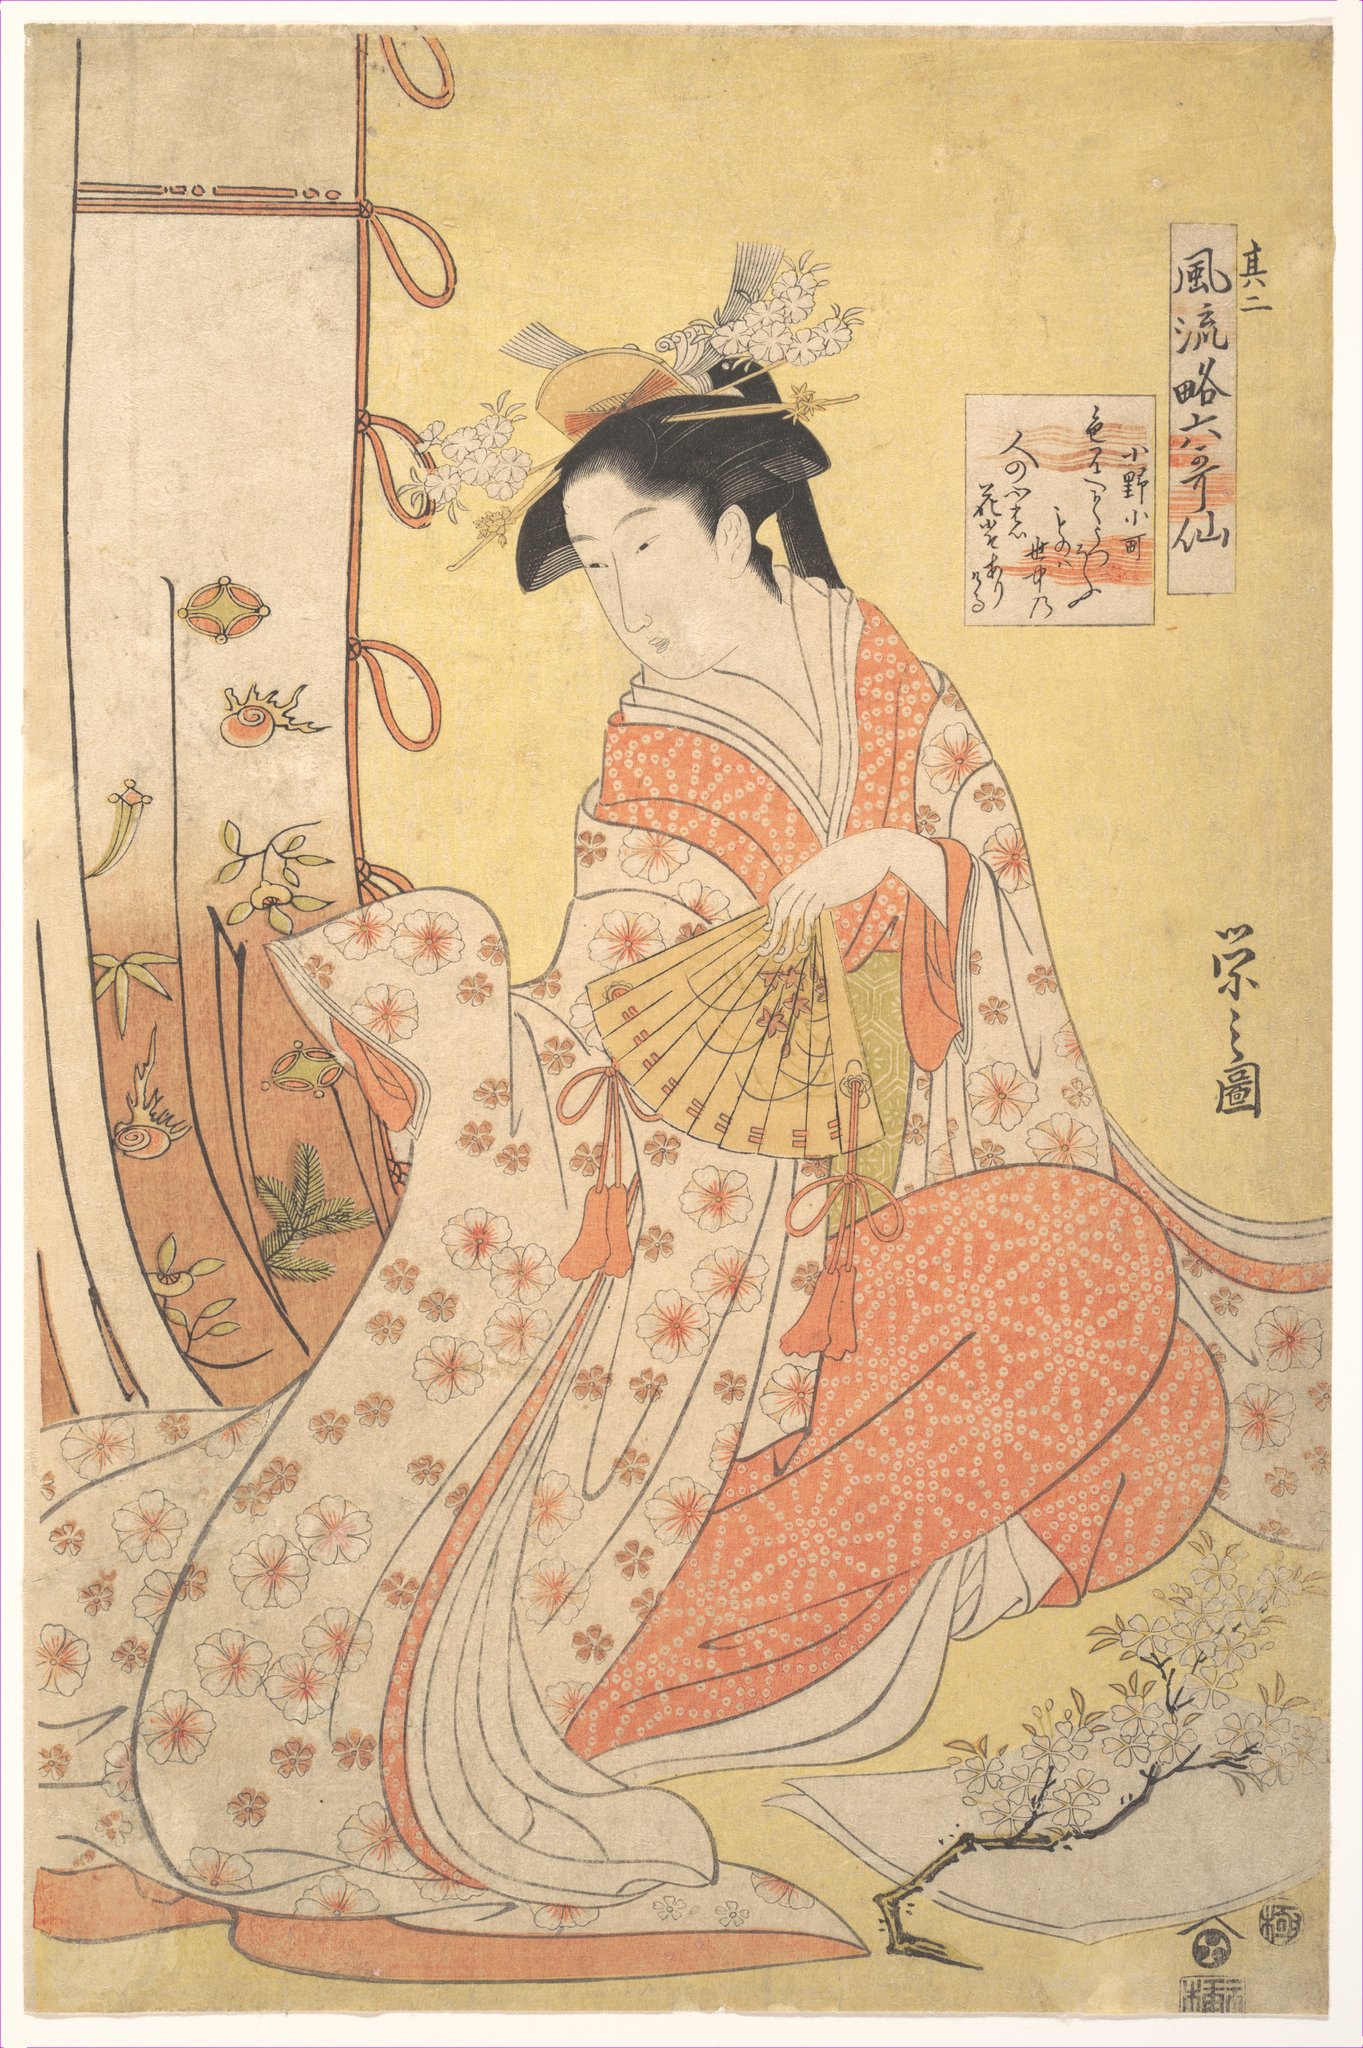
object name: print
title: Ono no Komachi: Number Two (Sono ni), from the series Stylish Parodies of the Six Poetic Immortals (Fūryū yatsushi rokkasen)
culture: japanese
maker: chōbunsai eishi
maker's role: artist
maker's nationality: japanese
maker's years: 1756-1829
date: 1790-1799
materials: ink, paper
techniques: woodblock print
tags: fans,women